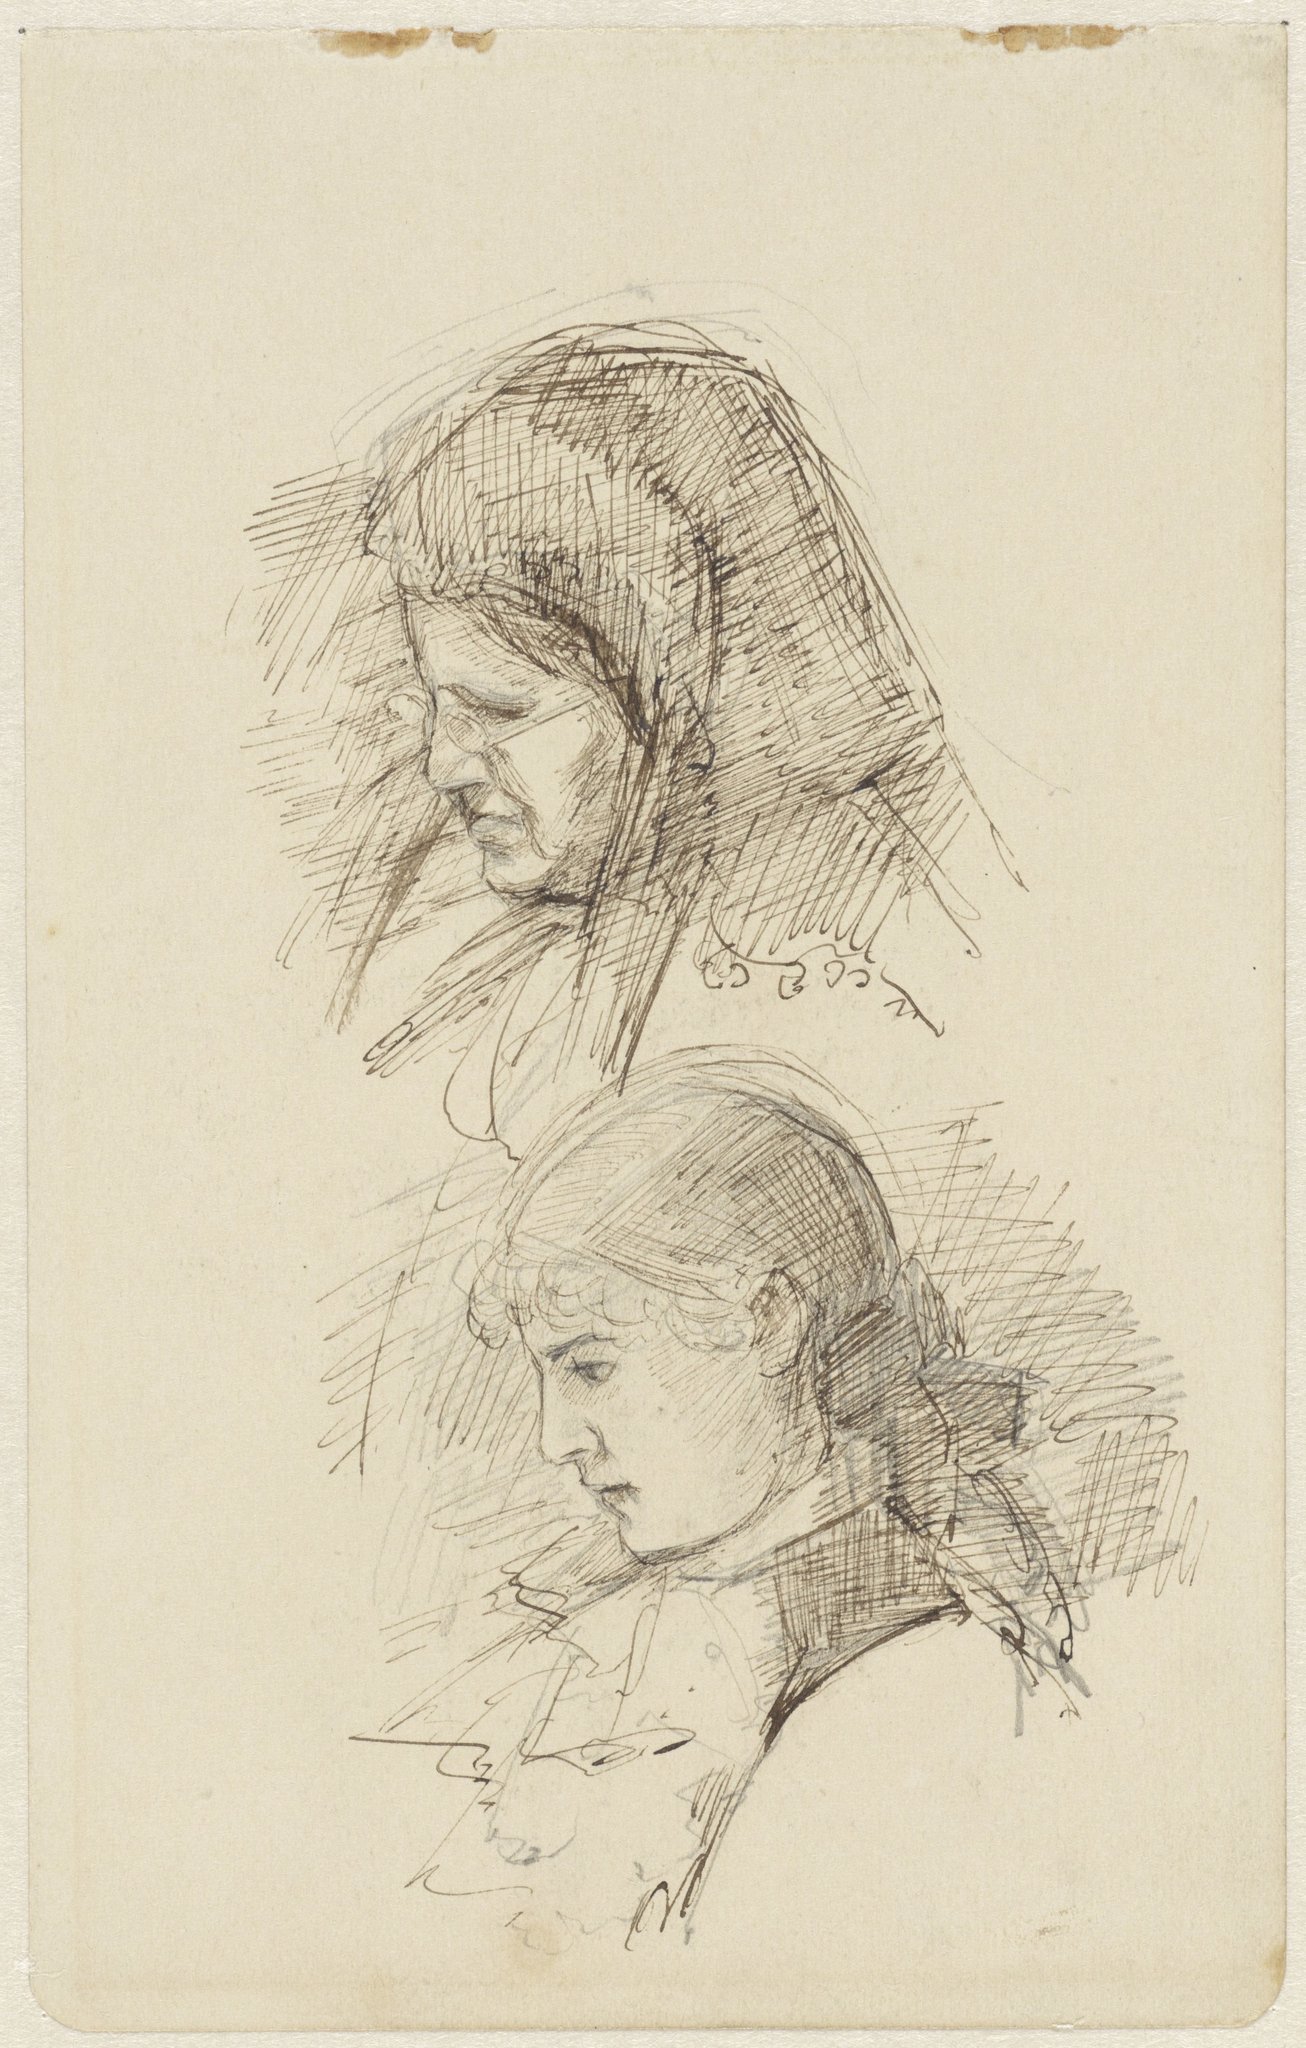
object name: drawing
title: Twee vrouwenhoofden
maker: jozef israëls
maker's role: draughtsman, painter, print maker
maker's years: 1824-1911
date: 1834-1911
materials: ink, paper, pencil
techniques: pen